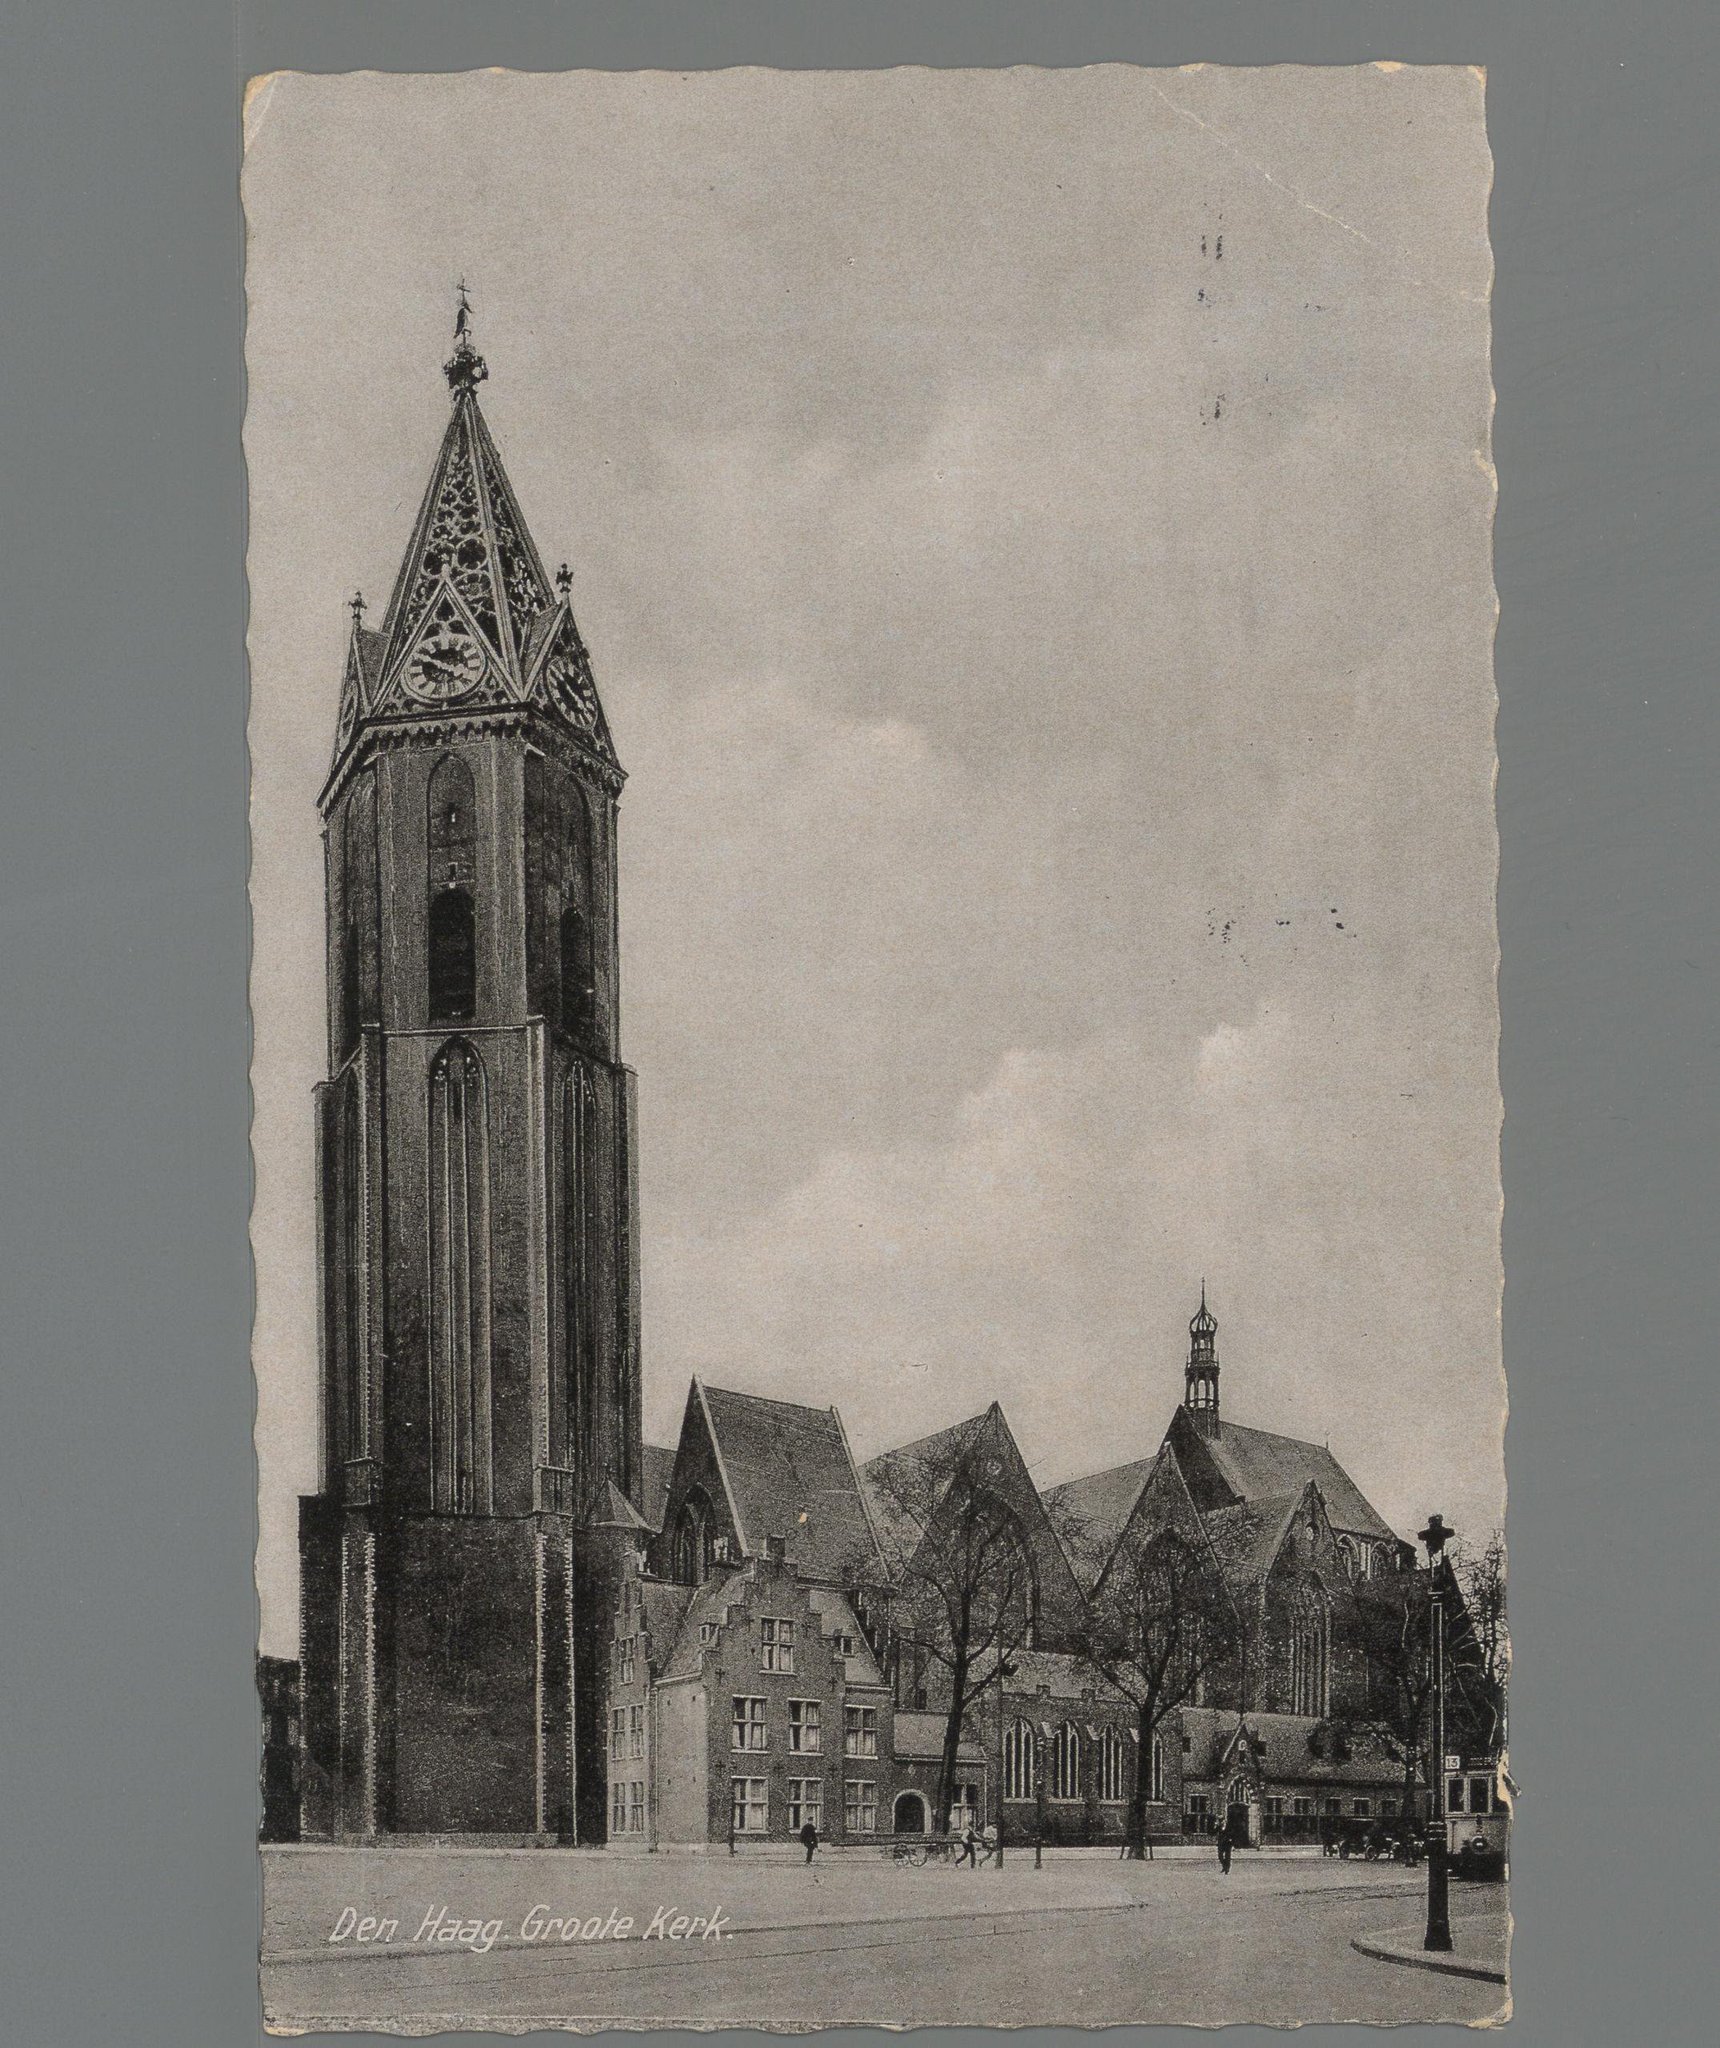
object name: photomechanical print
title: Den Haag. Groote Kerk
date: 1932-1941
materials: cardboard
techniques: photograph, writing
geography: the hague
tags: city-view, and landscape with man-made constructions, church (exterior)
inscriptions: postage stamp